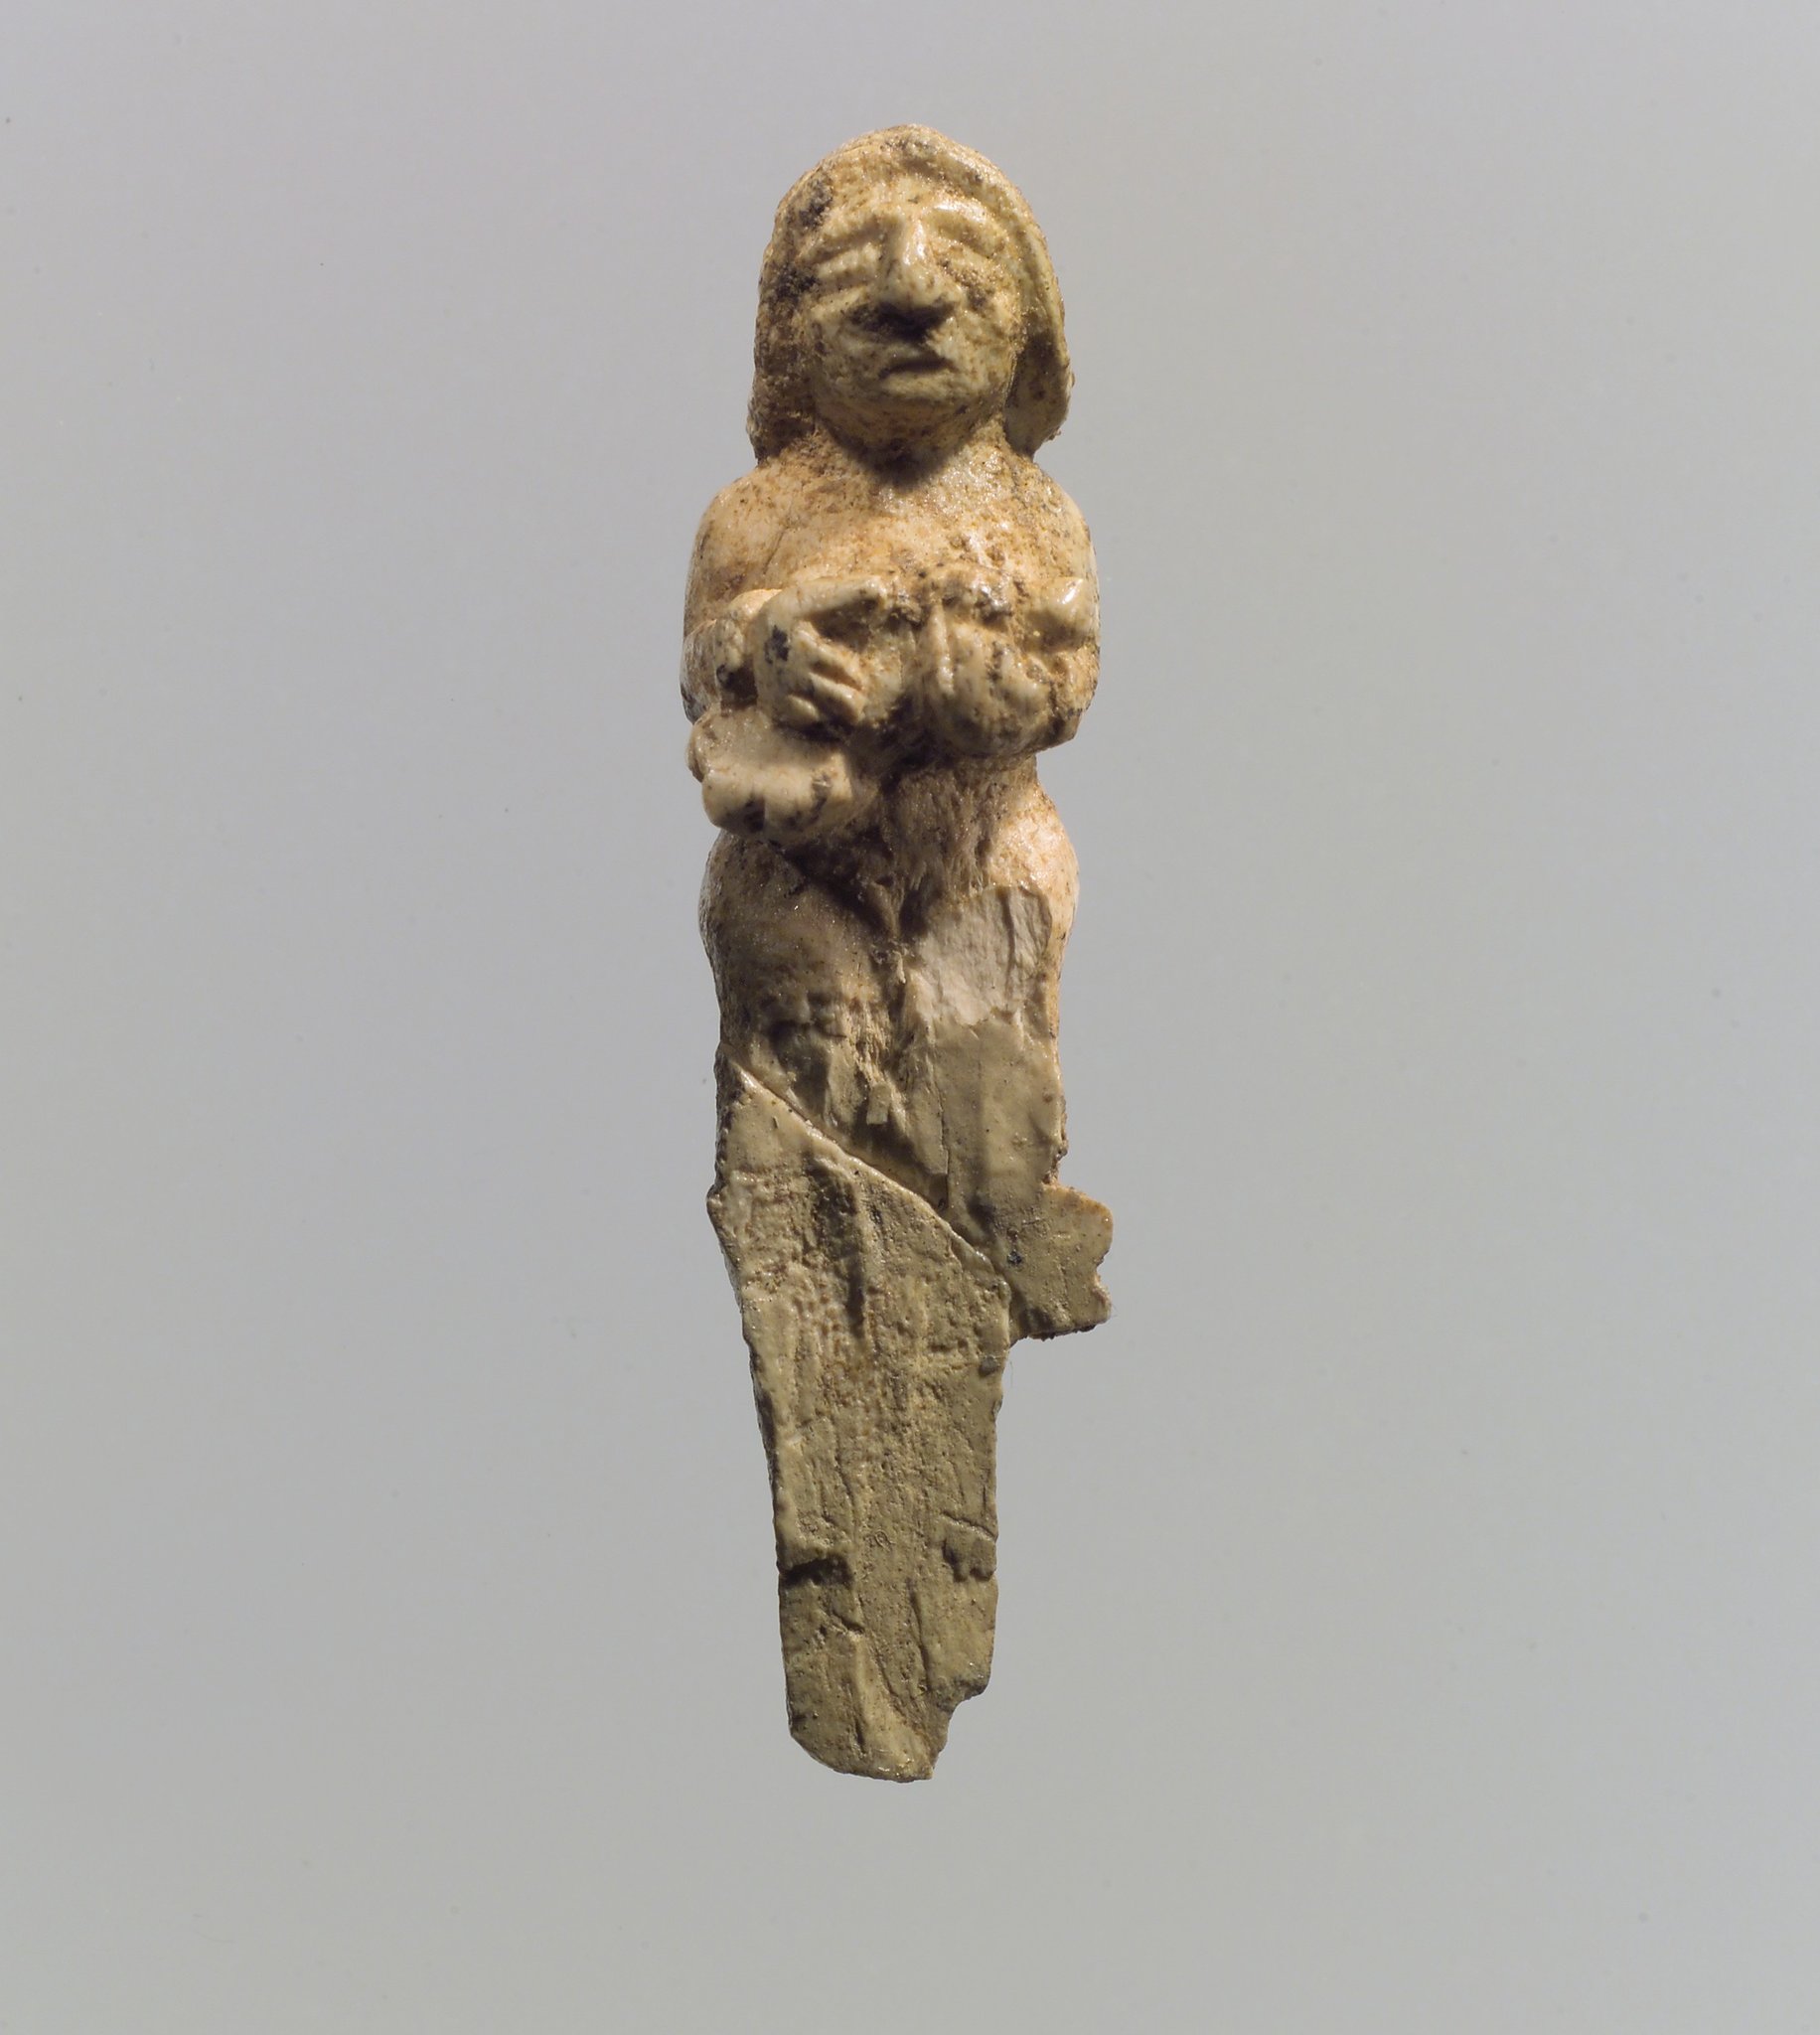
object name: sculpture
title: Figurine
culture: iranian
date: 800-601 BCE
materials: ivory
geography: iran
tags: women